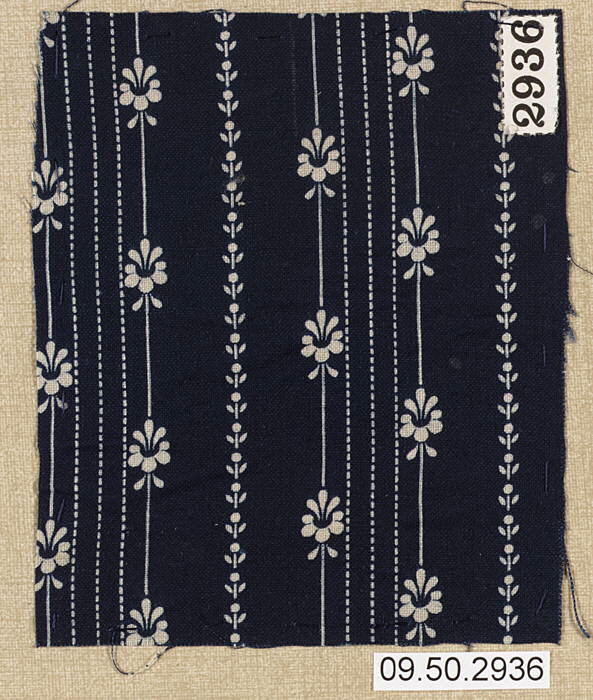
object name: piece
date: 1801-1900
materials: cotton